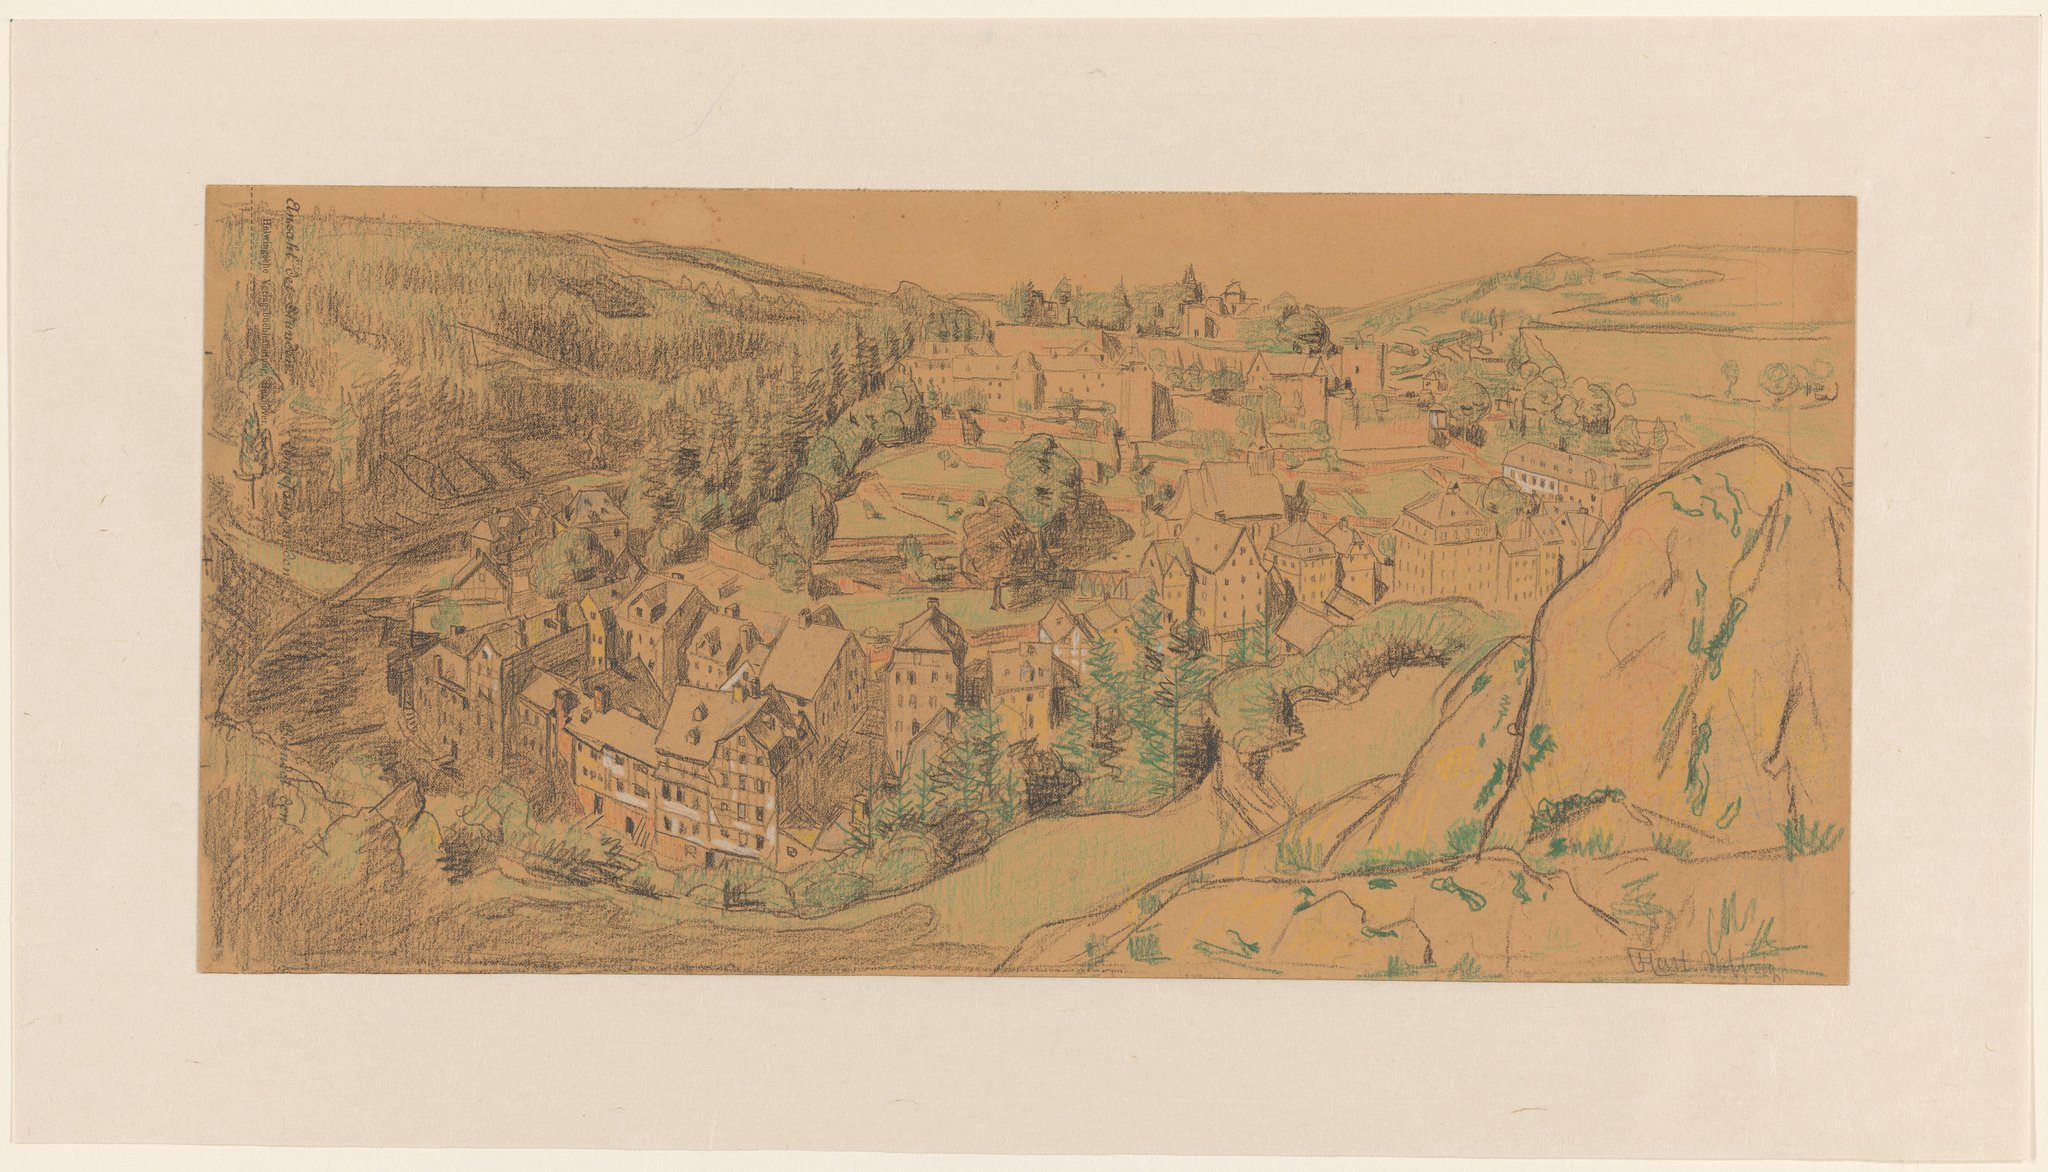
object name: drawing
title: Stad in de Eifel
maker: ferdinand hart nibbrig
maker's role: draughtsman, painter, print maker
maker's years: 1866-1915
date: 1876-1915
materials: chalk, paper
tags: dale, valley, germany